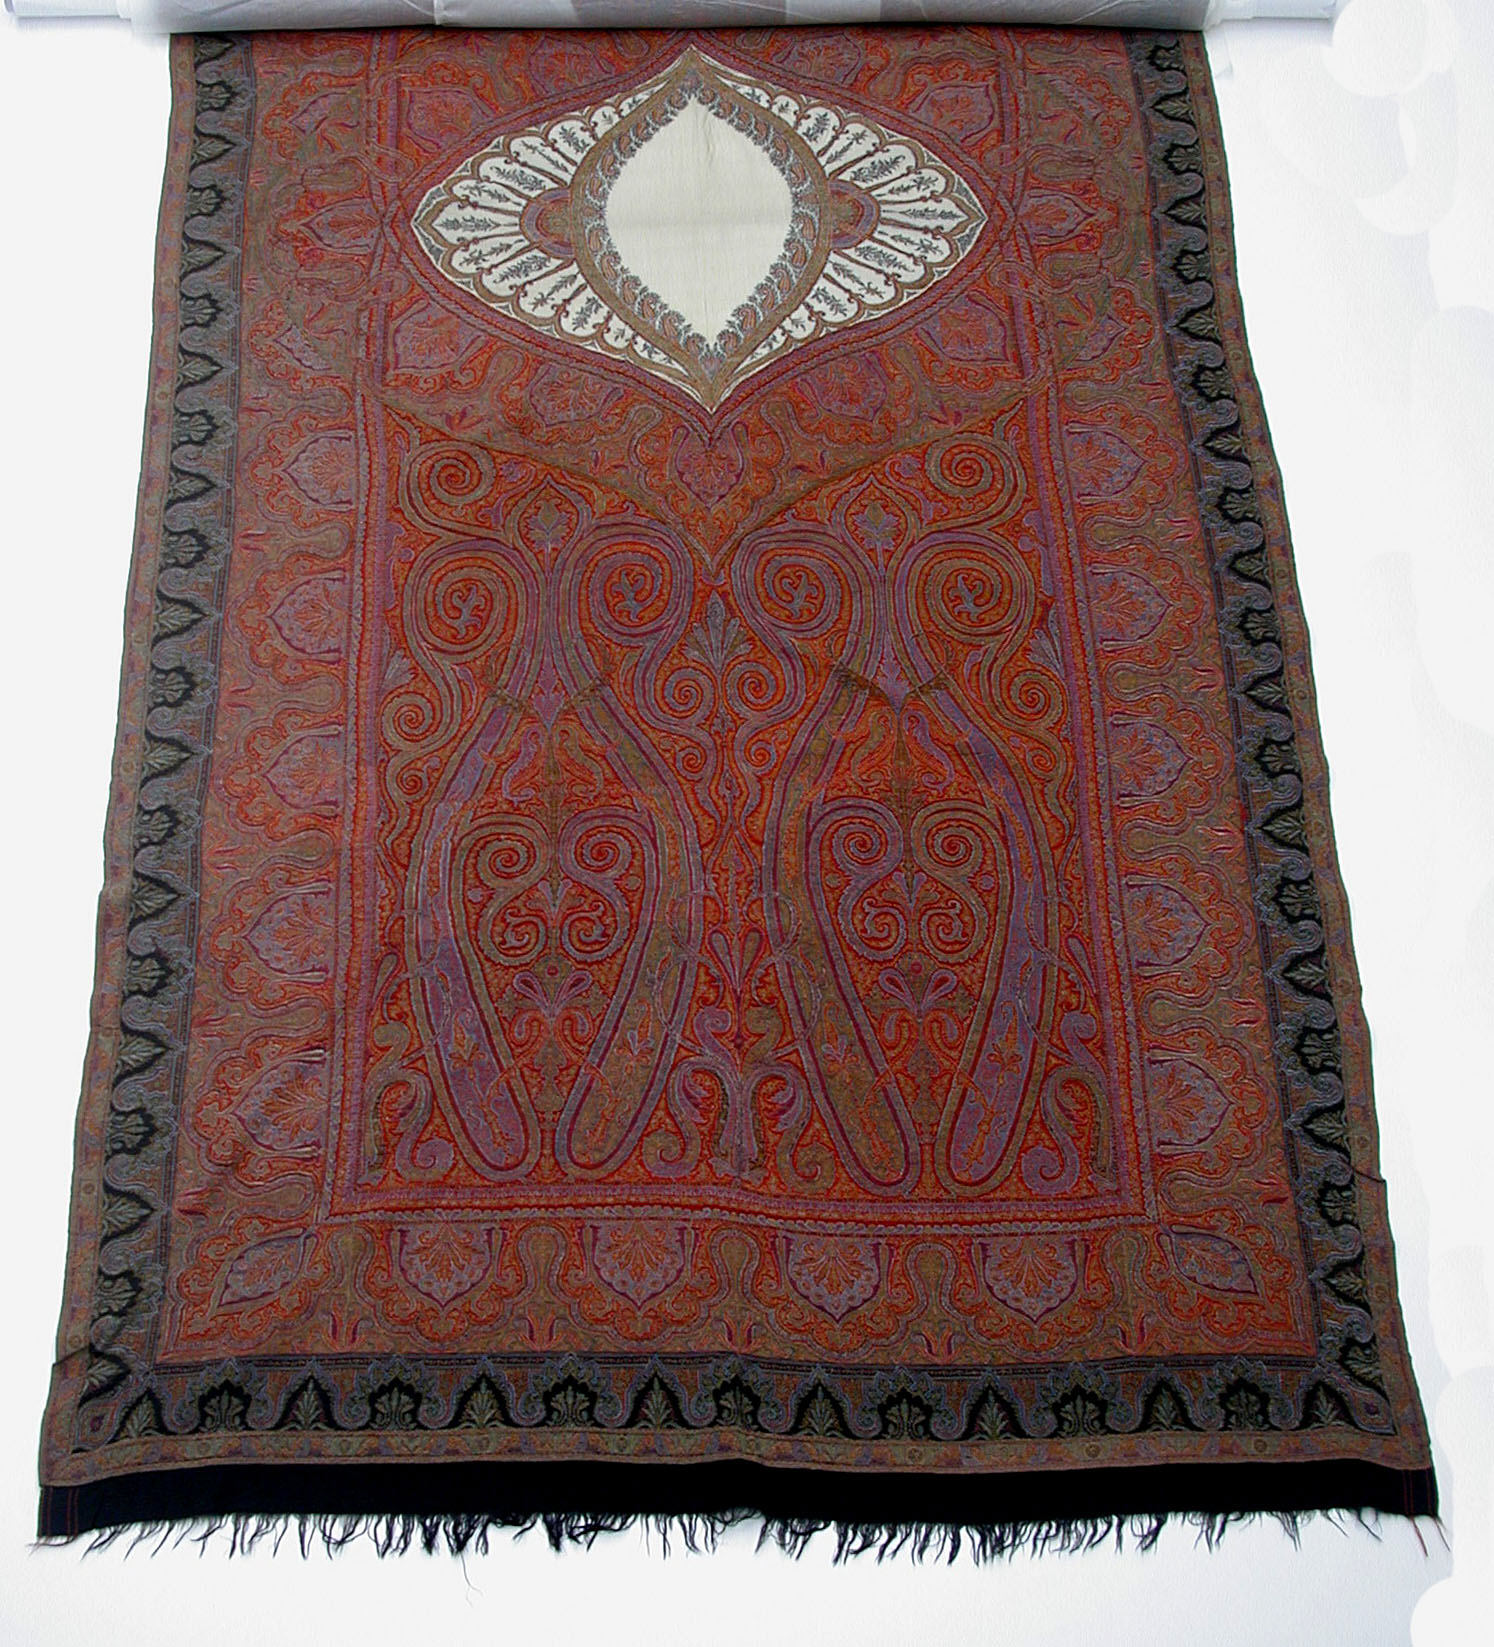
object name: cover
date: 1860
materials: wool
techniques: weave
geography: india